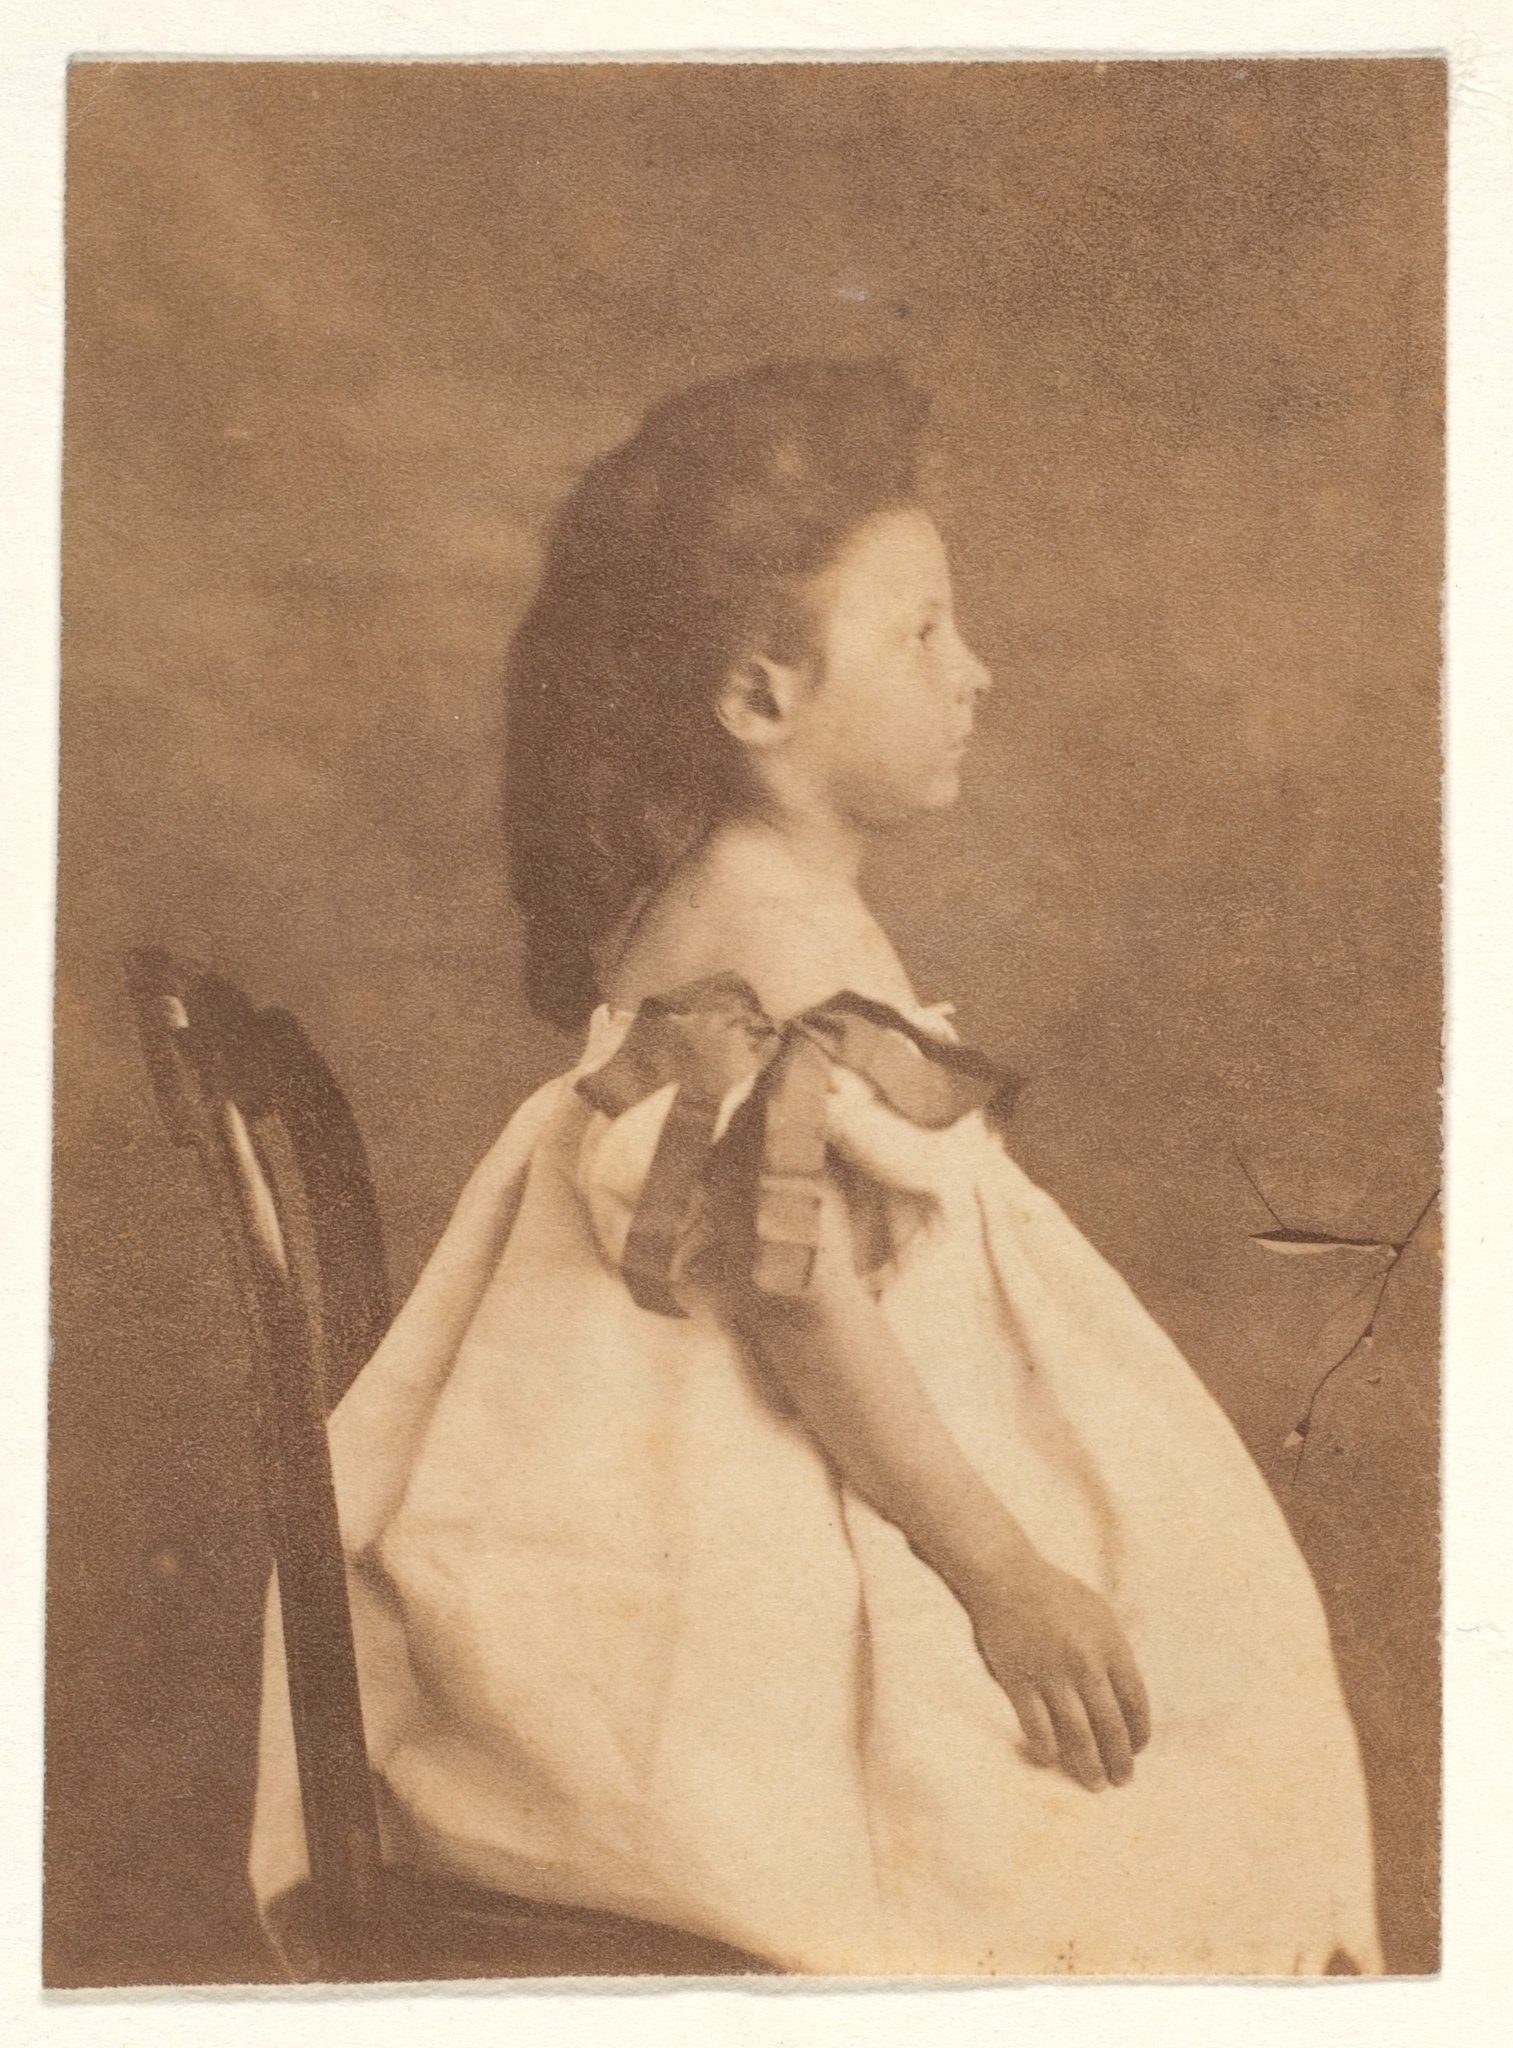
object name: photograph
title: Autre chaise rustique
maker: pierre-louis pierson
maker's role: artist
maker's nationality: french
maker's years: 1822-1913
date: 1860-1869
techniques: albumen silver print, glass negative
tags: girls,portraits,profiles